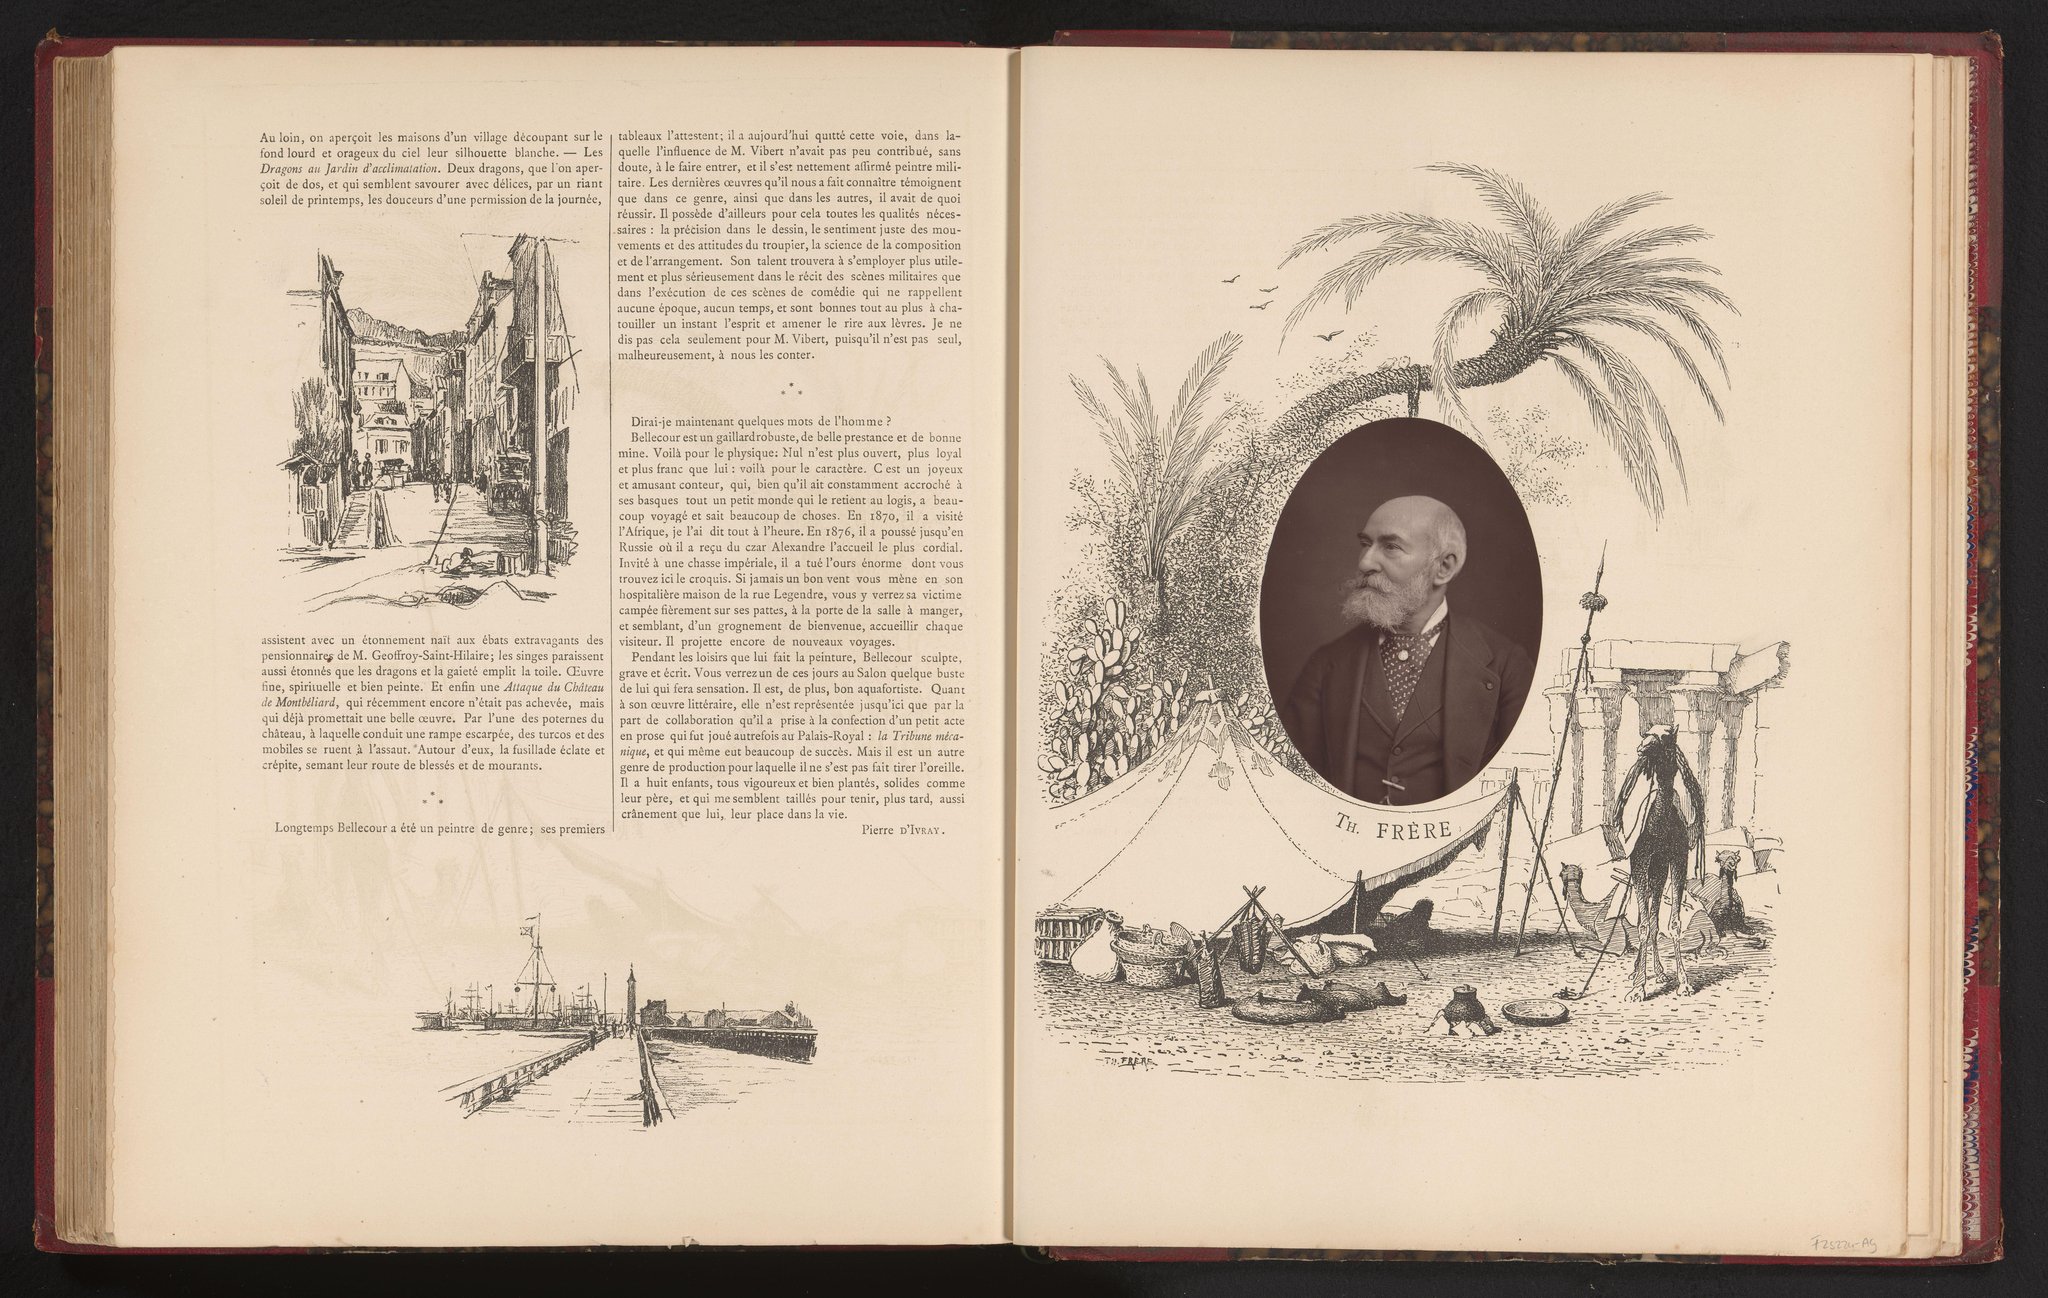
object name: photomechanical print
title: Th. Frère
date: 1867-1880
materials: paper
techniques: printing block, woodburytype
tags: paris, painter, théodore frère, adult man, historical persons